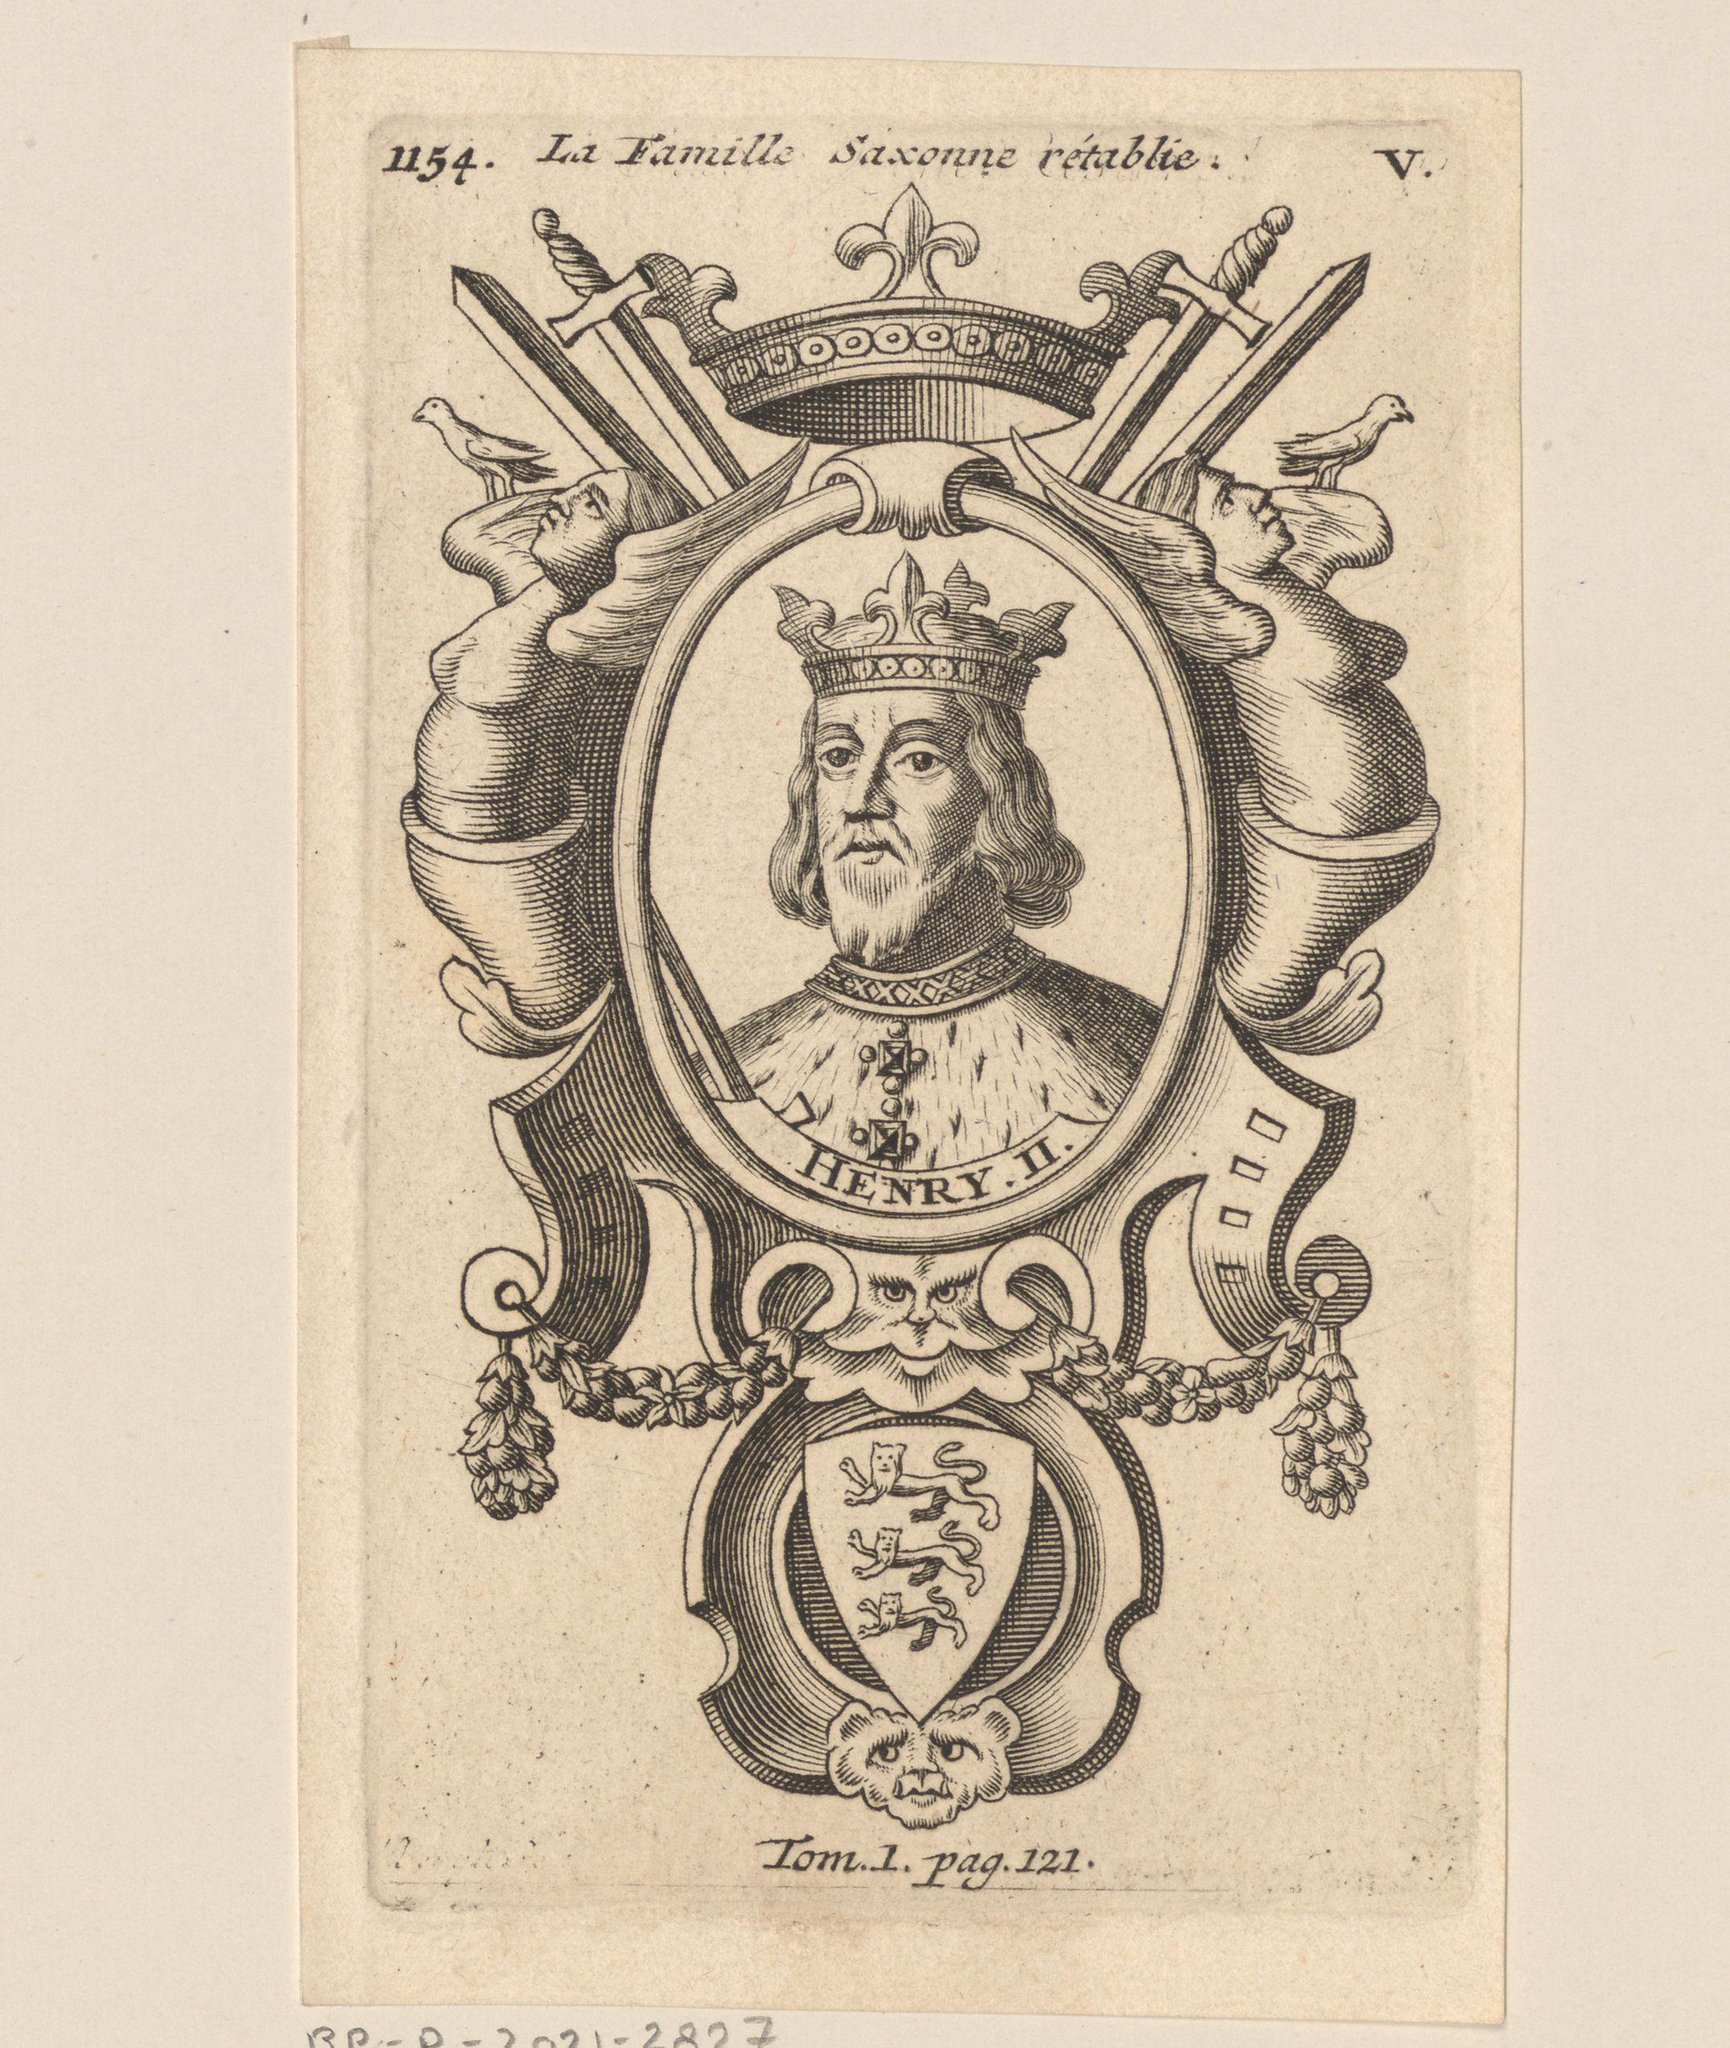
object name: book illustration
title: Portret van Hendrik II, koning van Engeland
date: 1714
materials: paper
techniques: engraving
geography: amsterdam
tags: historical persons, king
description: Prent uit: Orléans, Pierre-Joseph d'. Histoire des révolutions d'Angleterre (...). Amsterdam: David Mortier, 1714, dl. 1. Prent mogelijk ook gebruikt in andere publicaties.